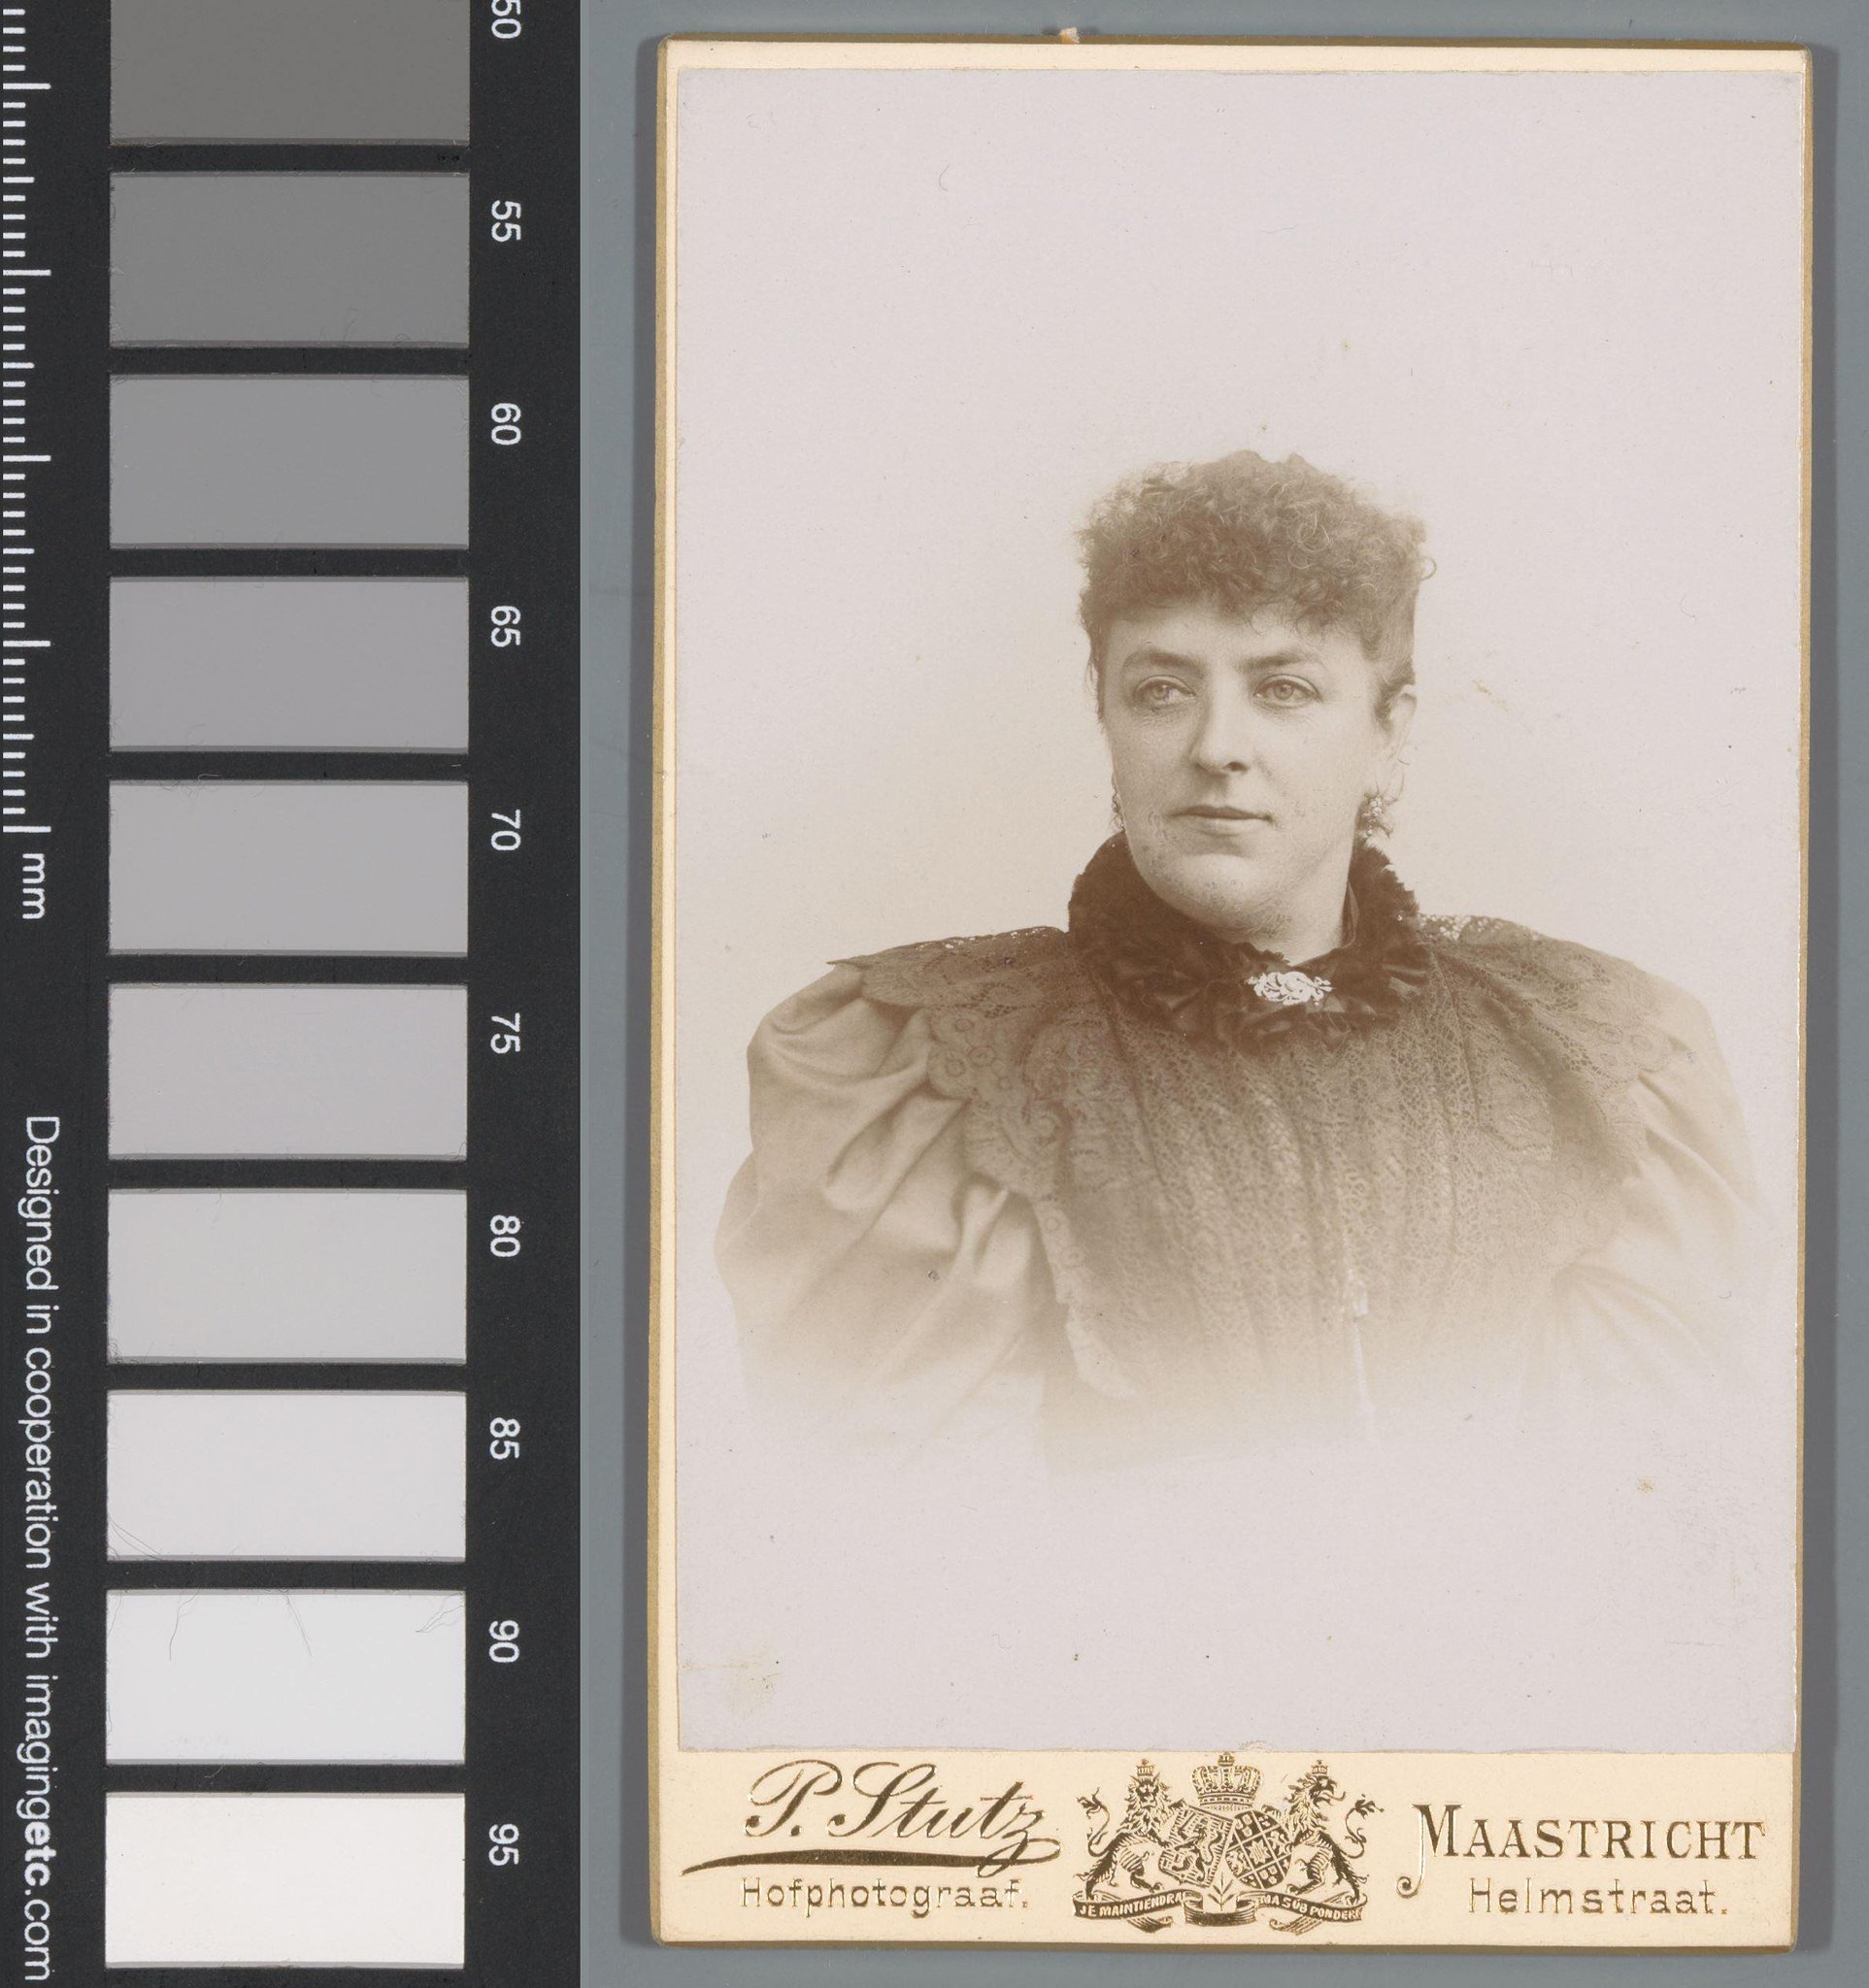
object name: carte de visite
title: Portret van een onbekende vrouw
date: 1888-1913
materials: cardboard, photographic support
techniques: collodion silver print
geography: maastricht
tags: historical persons - bb - woman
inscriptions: inscription: ‘Bekroond met de Gouden Medaille 1894/ FIrma P. Stutz/ Hofphotograaf/ MAASTRICHT./ Telefoon No. 149./ Specialiteit in onveranderlijke Crajionportretten. / G. Janssen & Co. Cöln a/Rh.’